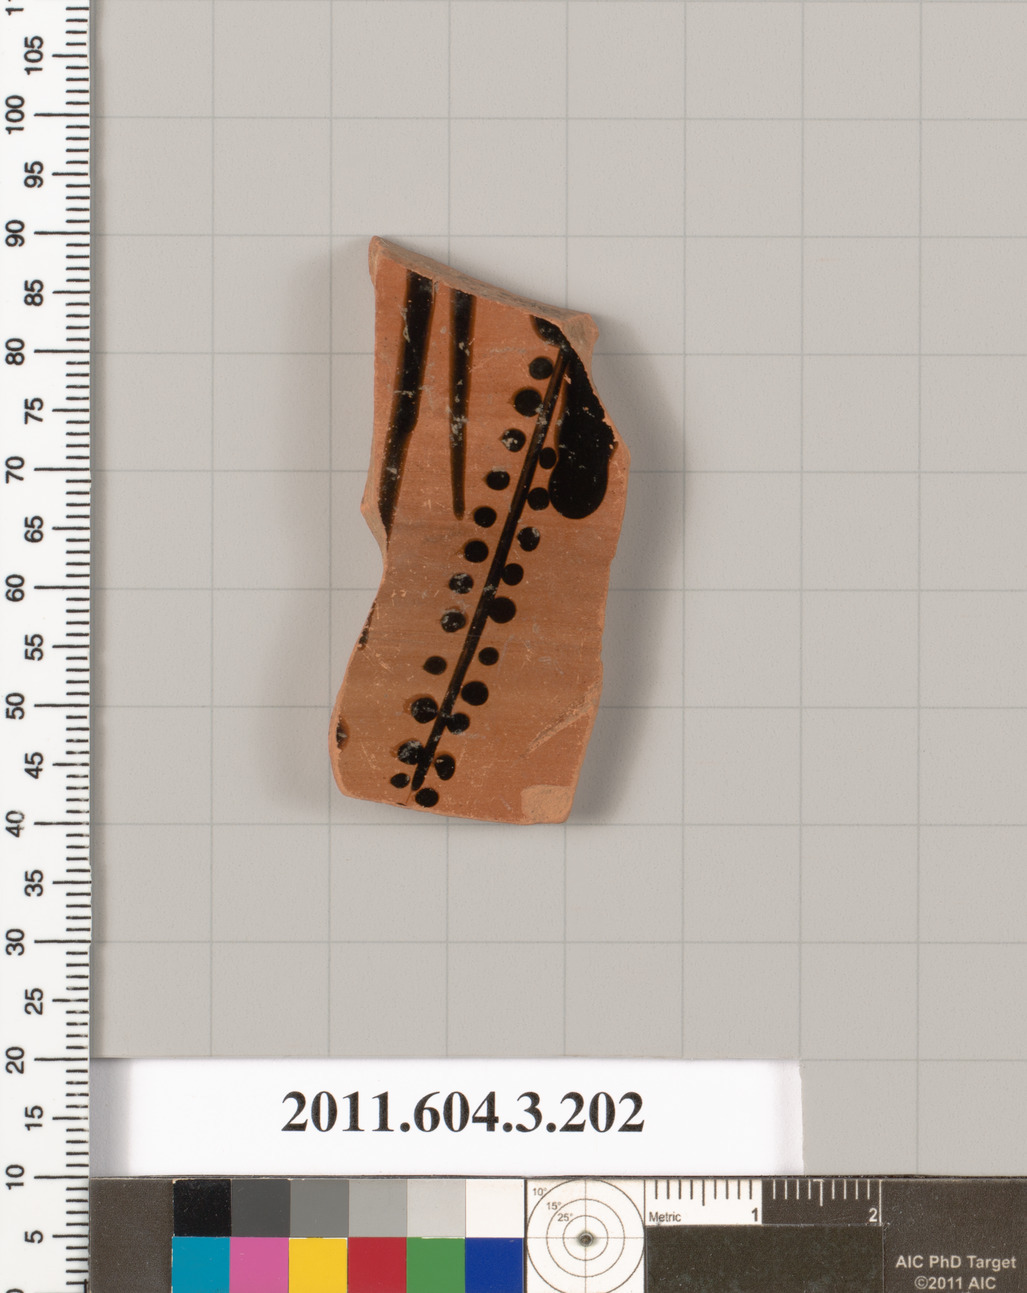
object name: neck amphora fragment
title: Terracotta fragment of a neck-amphora (jar)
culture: greek, attic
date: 530-520 BCE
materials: terracotta